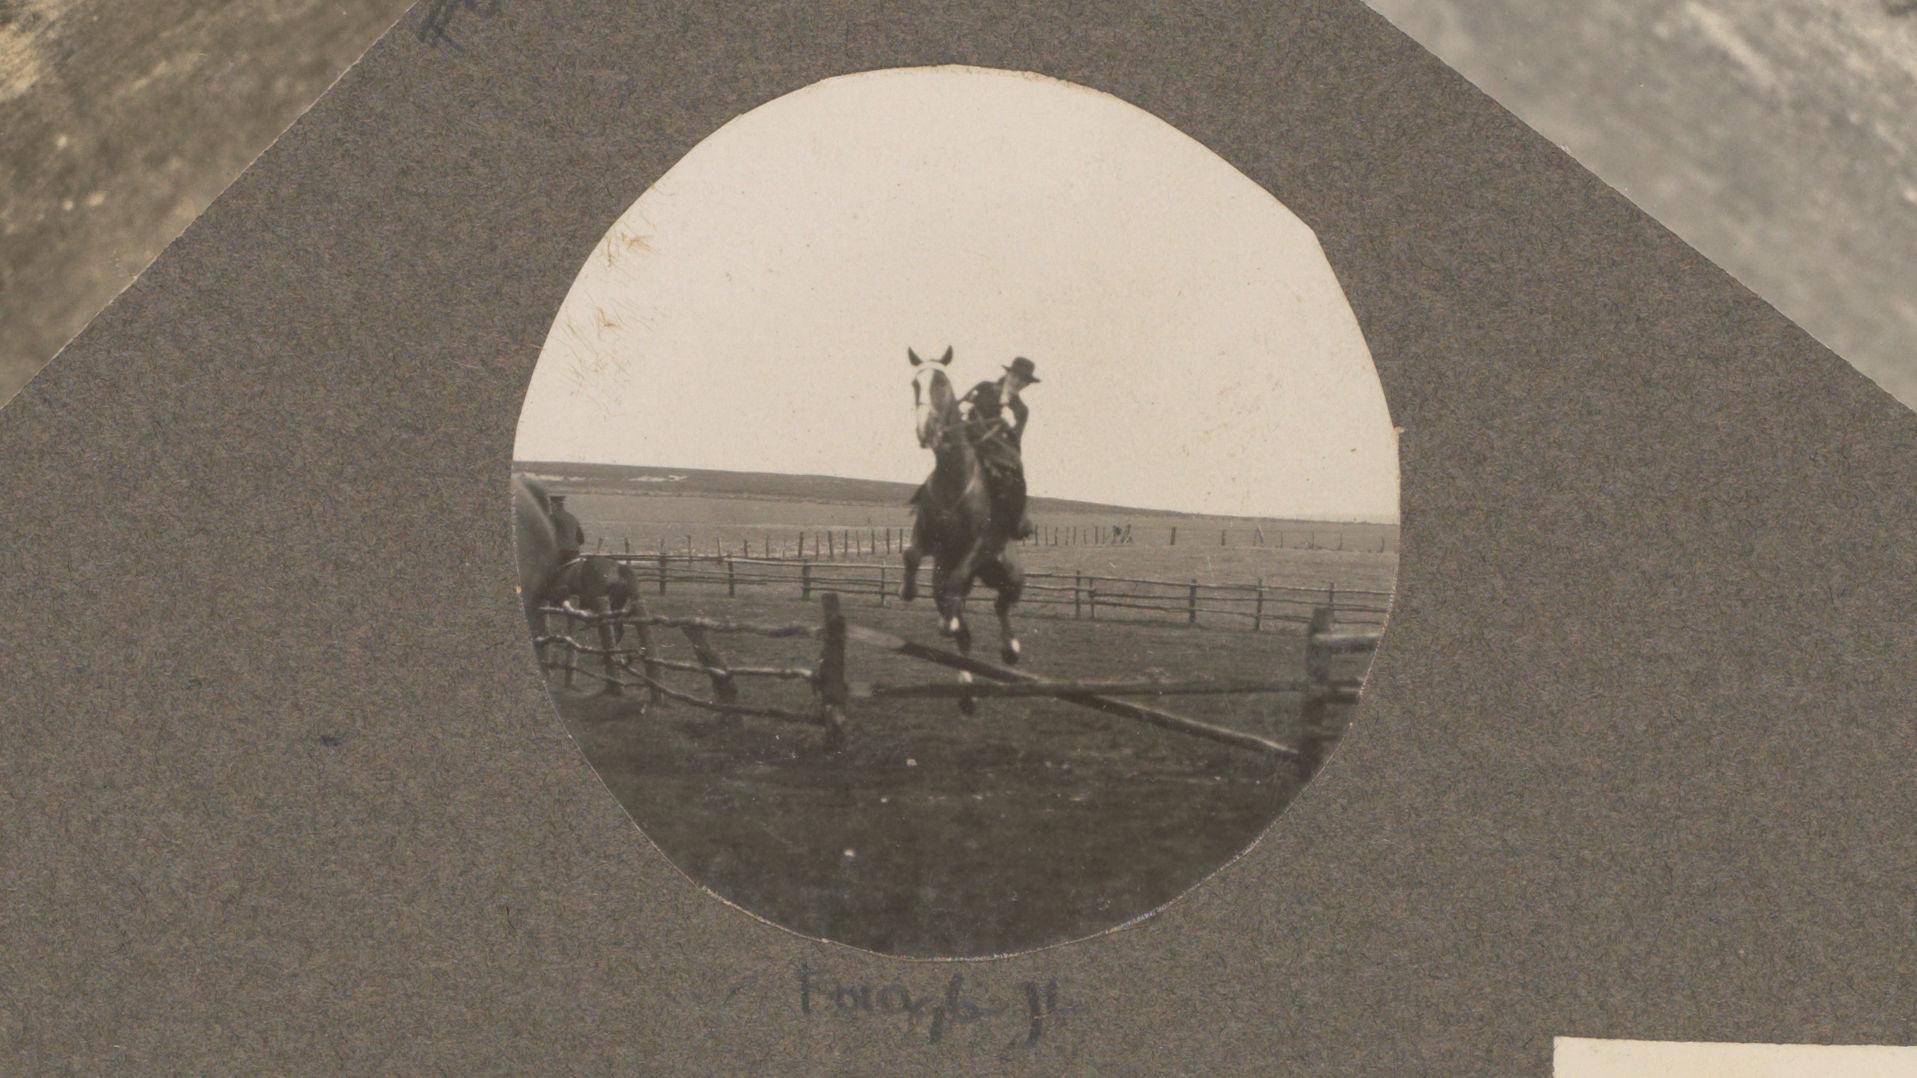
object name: album leaf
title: Ruitertafereel op Koninklijke Houtvesterij Het Loo: ruiter in amazonezit neemt hindernis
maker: Anonymous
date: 1900-1925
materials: photographic support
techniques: gelatin silver print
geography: het loo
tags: riding a horse, ass, or mule; rider, horseman, hunting, chase, hunting-ground, jumping (horse in motion)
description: Onderdeel van Fotoalbum van de heer Brams, opperhoutvester van koningin Wilhelmina op Koninklijke Houtvesterij Het Loo.